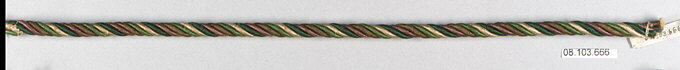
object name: cord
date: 1701-1900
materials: metal thread, silk